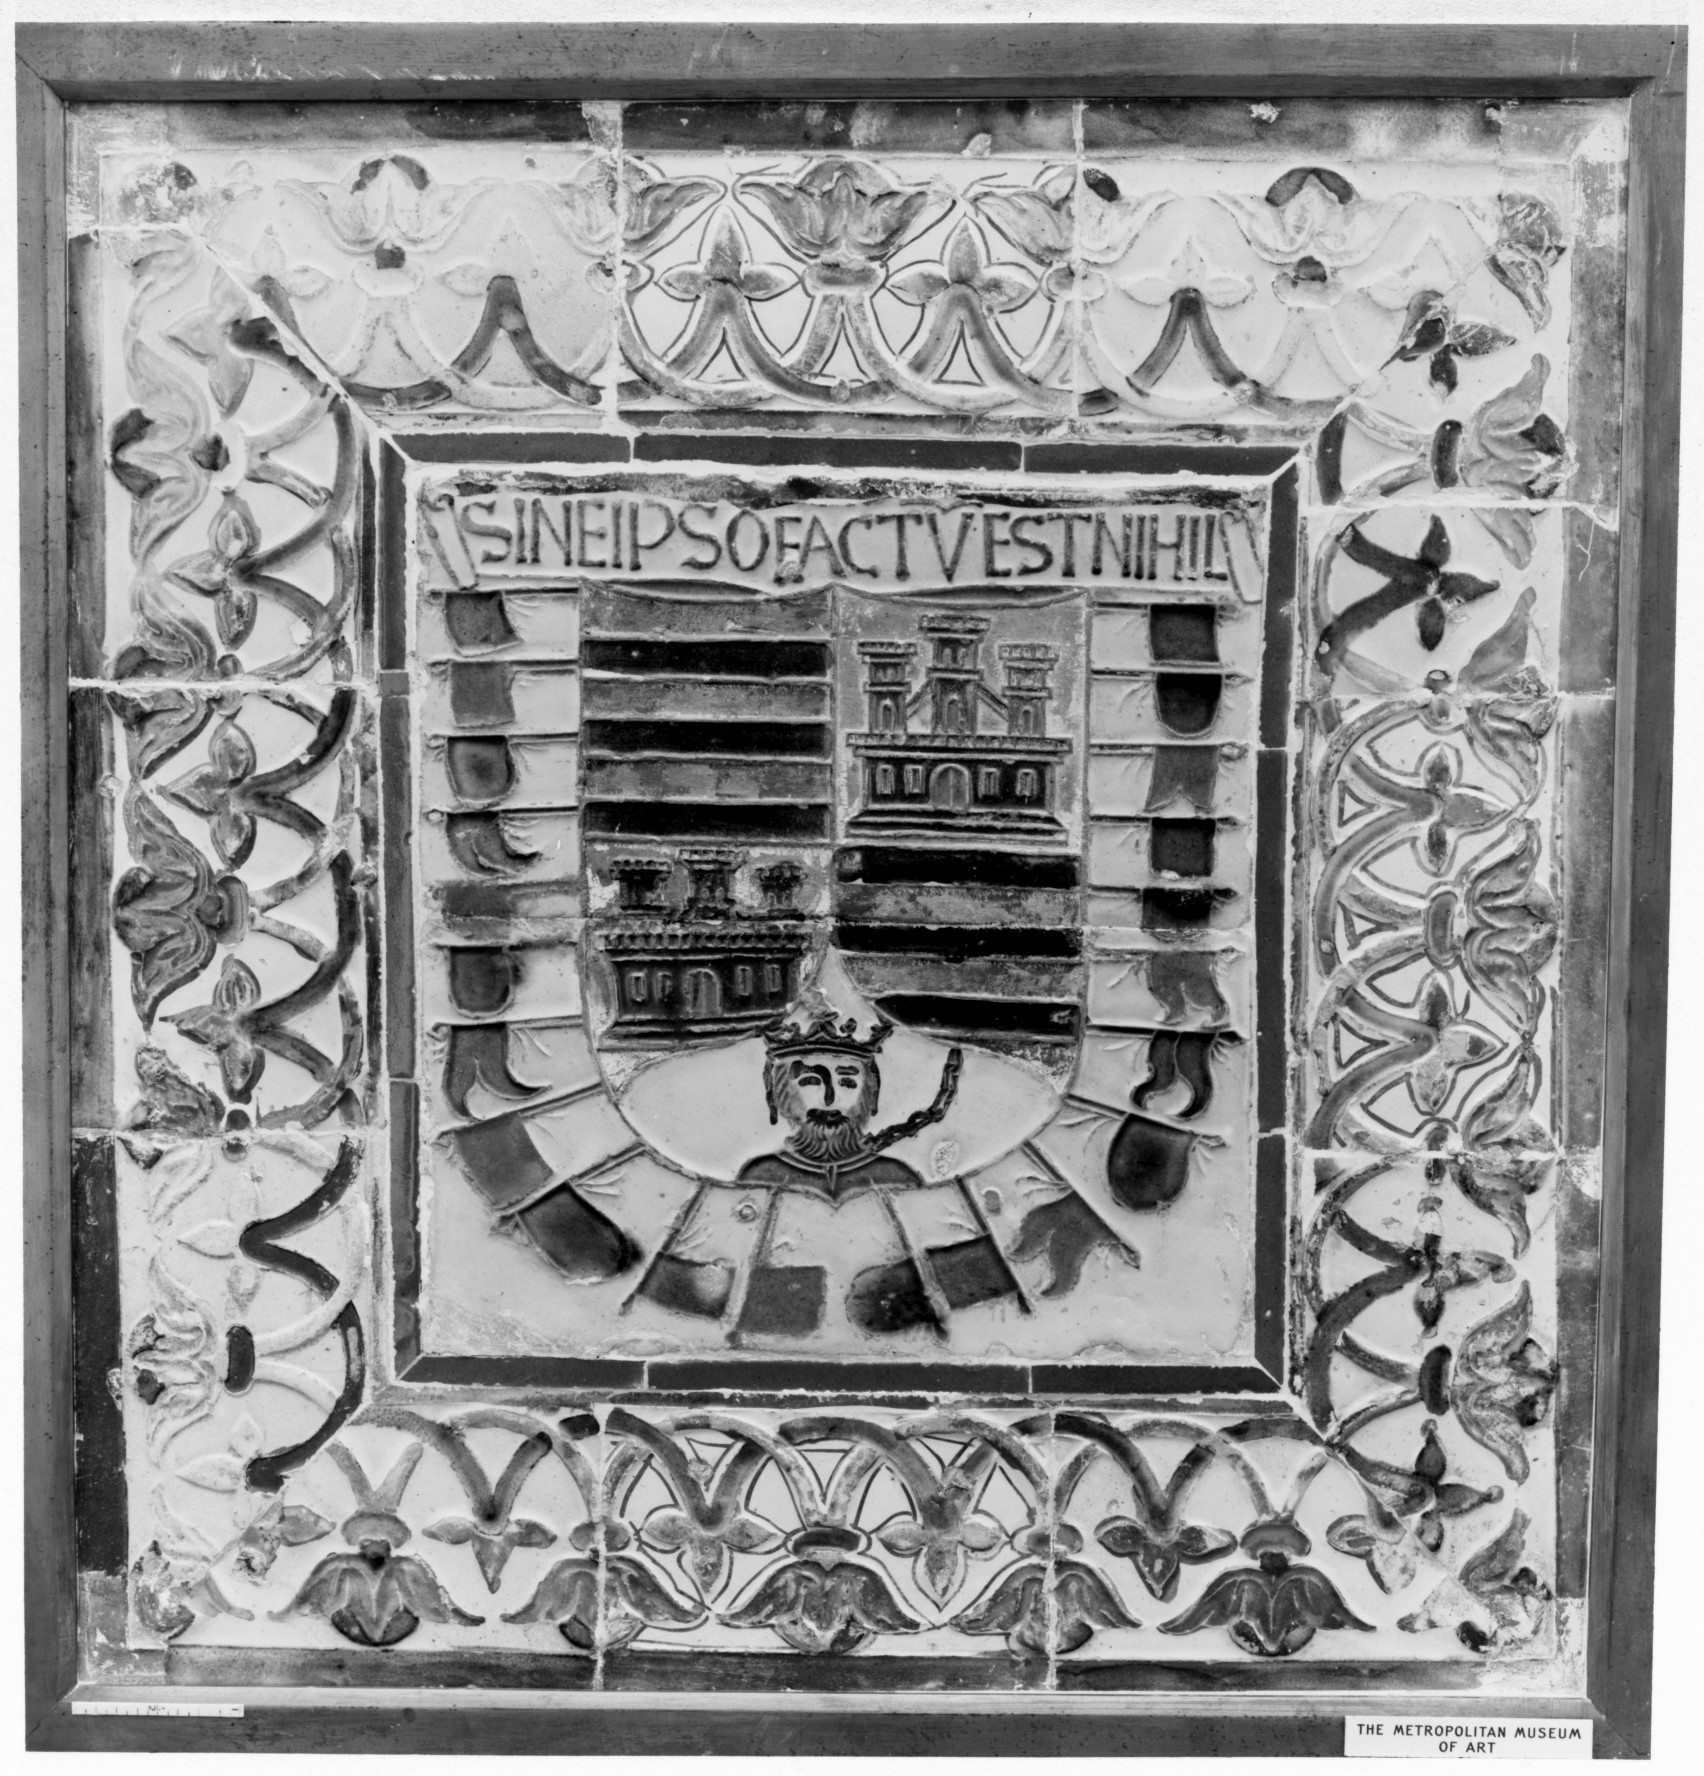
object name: tile panel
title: Wall panel tiles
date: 1501-1600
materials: earthenware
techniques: glazing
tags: coat of arms